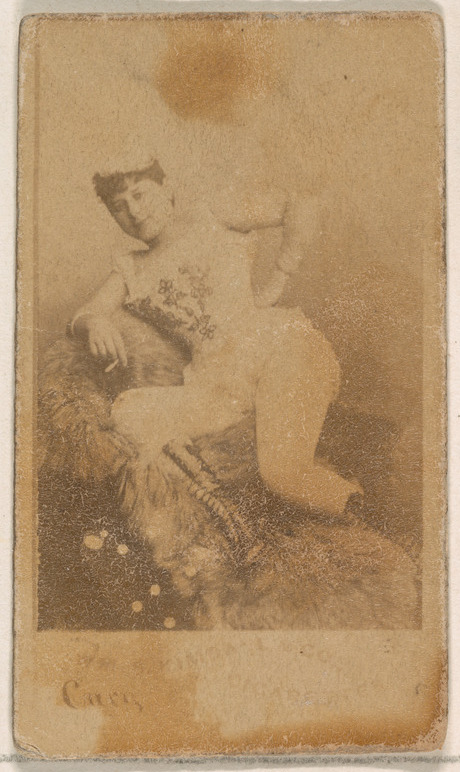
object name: photograph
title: Miss Cary, from the Actresses series (N203) issued by Wm. S. Kimball & Co.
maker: william s. kimball & company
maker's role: publisher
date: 1889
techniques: color lithograph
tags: portraits,women,actresses